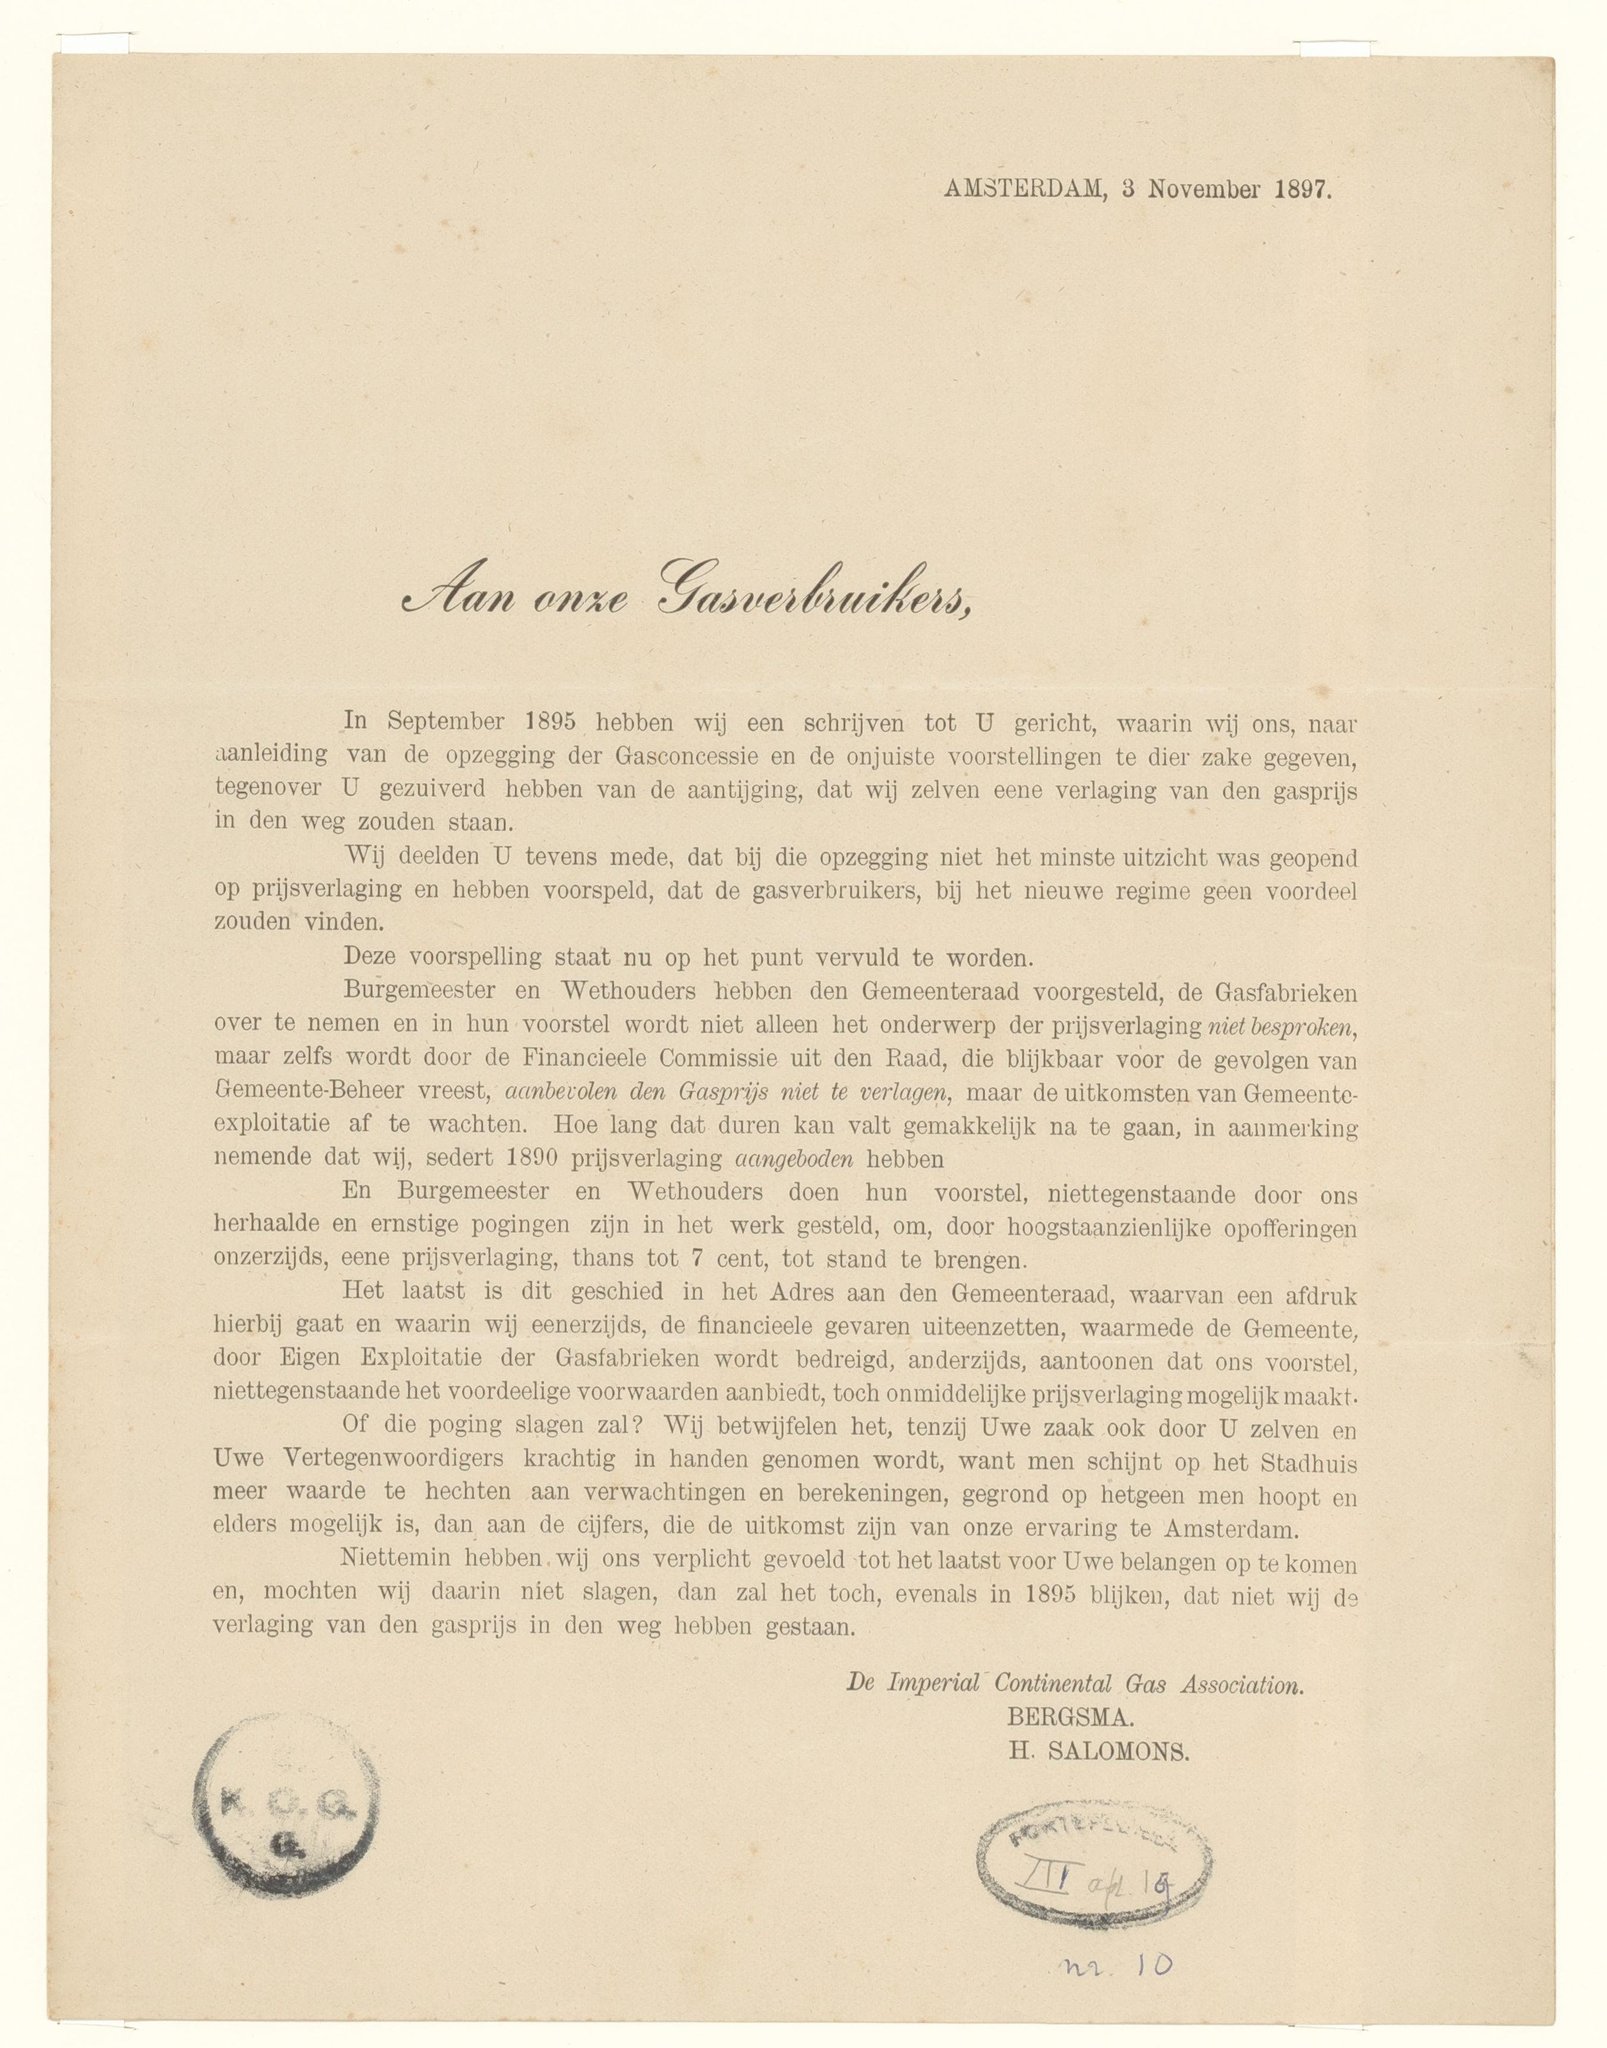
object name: text sheet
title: Brief aan de gasgebruikers van Amsterdam over het overnemen van de gasfabrieken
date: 1897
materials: paper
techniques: letterpress printing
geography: amsterdam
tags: gas extracted from coal, amsterdam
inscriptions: stamp, collector's mark: Lugt 1641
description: Brief aan de gasgebruikers van Amsterdam over het overnemen van de gasfabrieken van Imperial Continental Gas Associaton door de gemeente Amsterdam en prijsverlagingen. Vierbladig tekstblad alleen op de voorzijde bedrukt. Onderwerpsrubrieken binnen de Atlas Zeden en Gewoonten: Regeering, Telefoon, Gas, electriciteit.